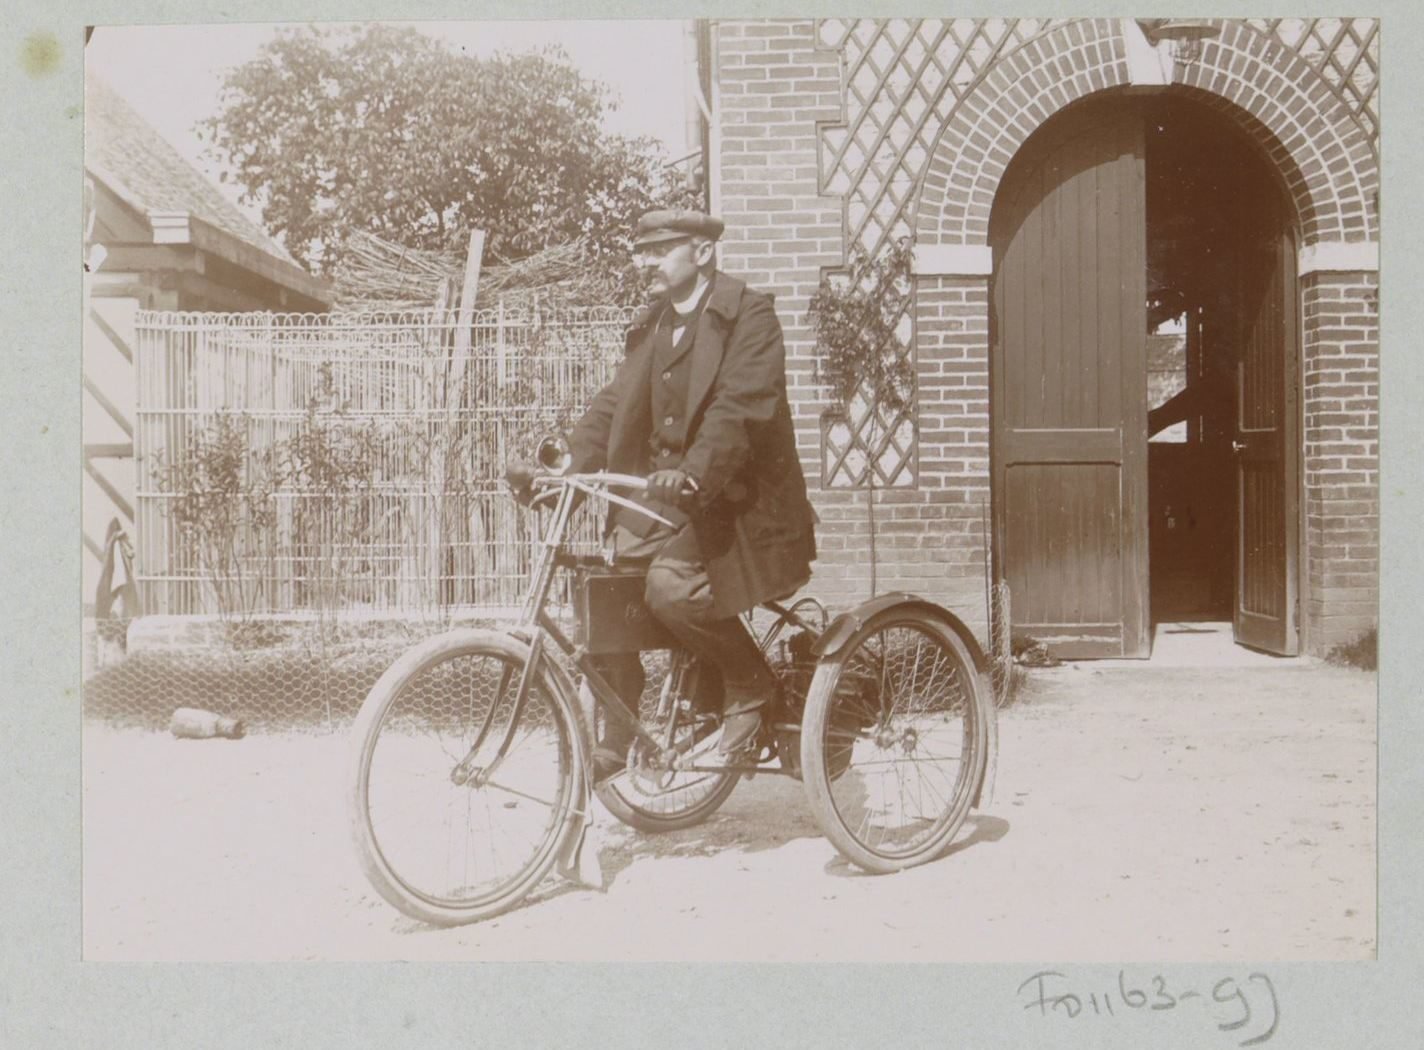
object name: photograph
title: Man op een gemotoriseerde driewieler in Frankrijk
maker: delizy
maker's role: manufacturer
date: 1898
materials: paper, photographic support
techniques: gelatin silver print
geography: france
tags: motor-cycles and other two-wheeled motor-vehicles, tricycle, france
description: Onderdeel van Fotoalbum van een Franse amateurfotograaf met opnames van uitstapjes in Frankrijk, Spanje, België, Luxemburg en Nederland, de eerste automobielen en autoraces.